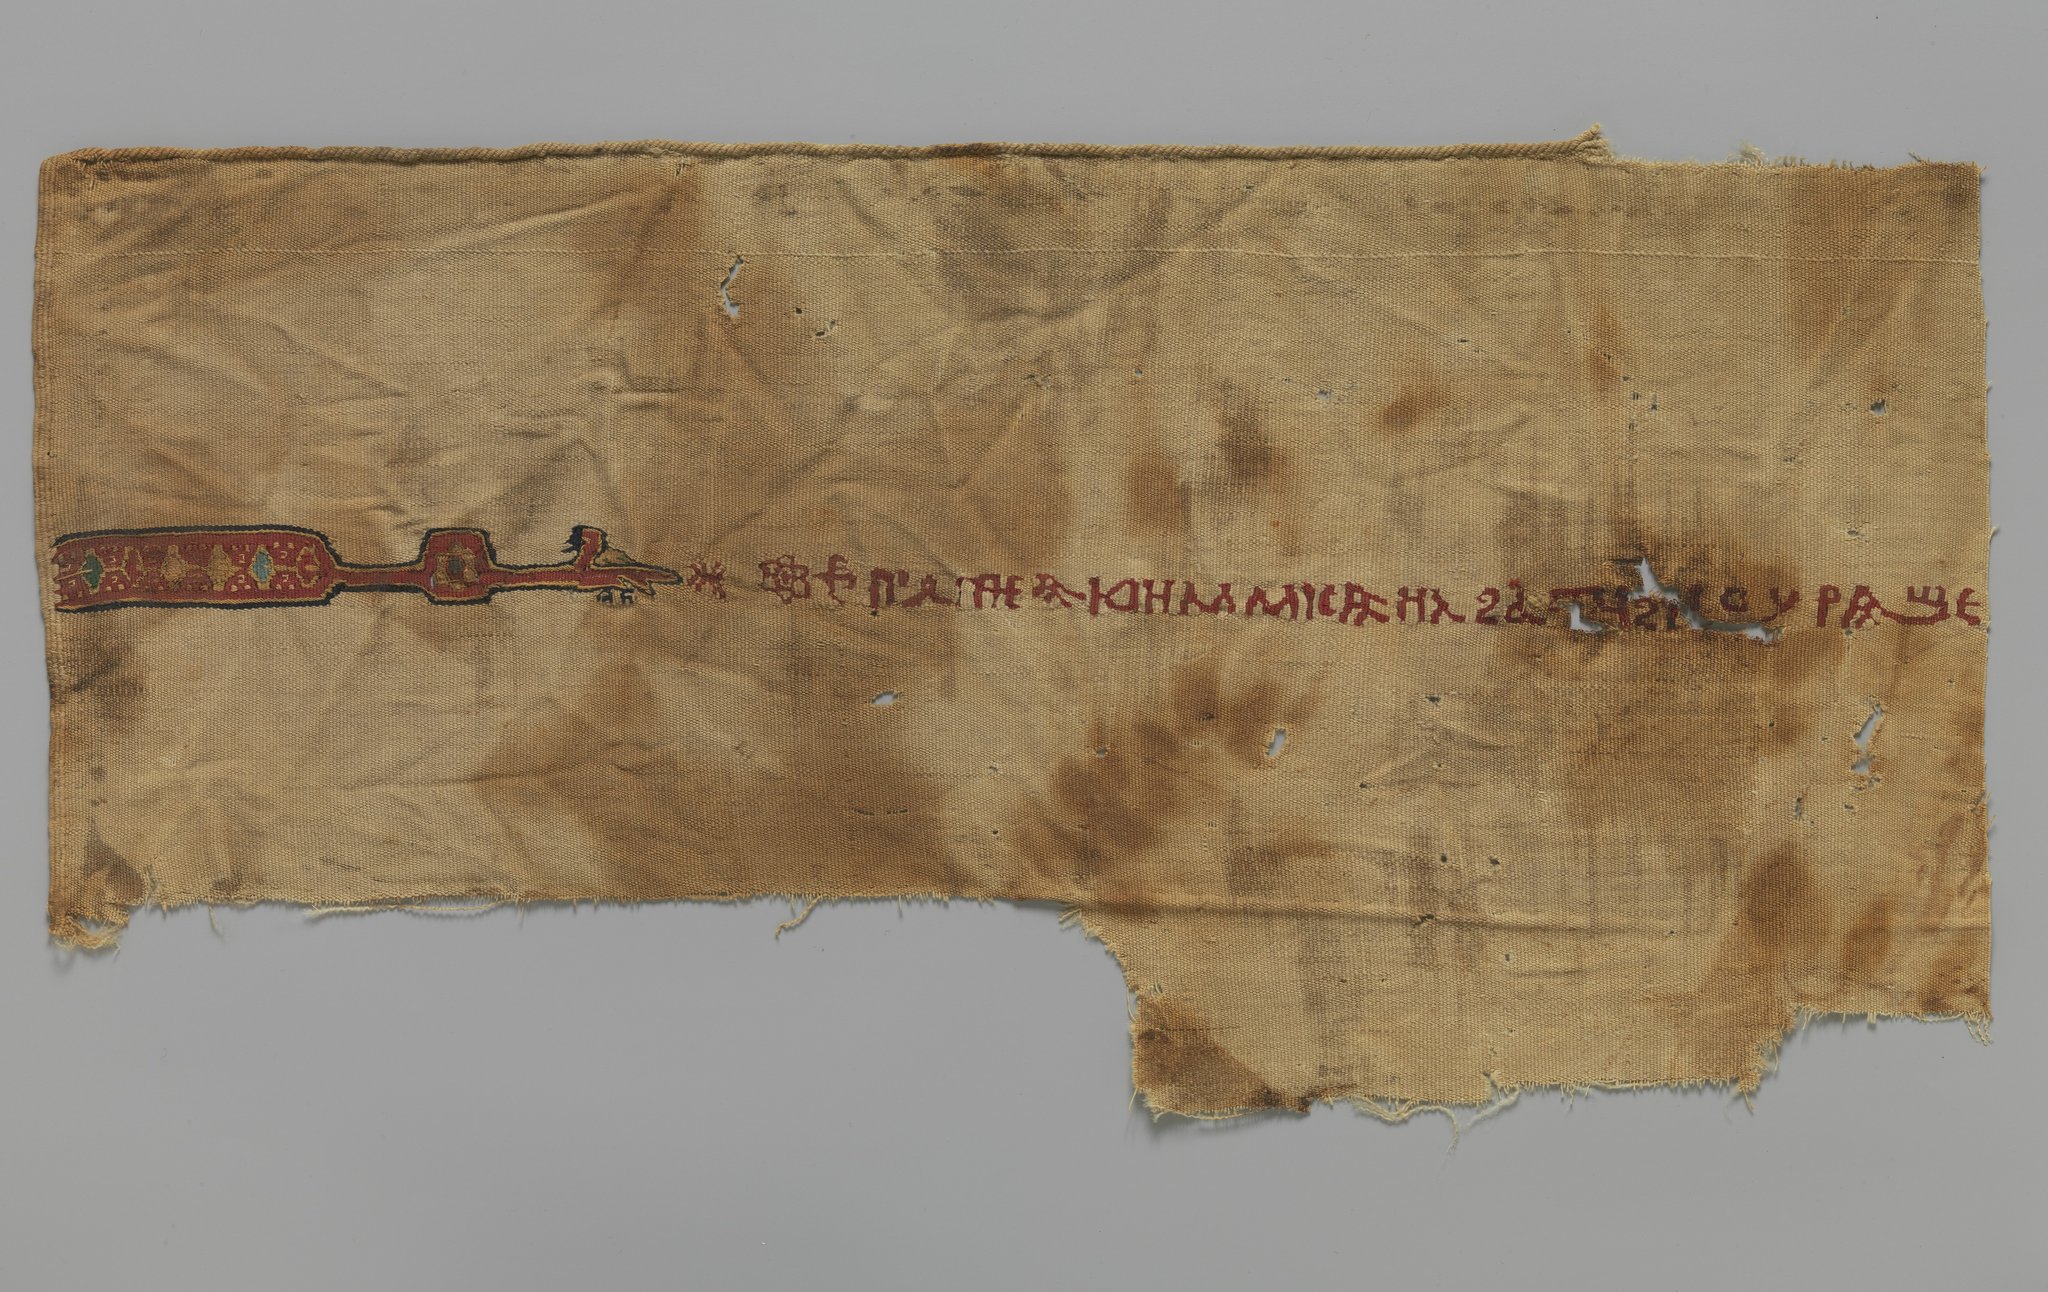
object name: textile fragment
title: Three Fragments with a Coptic Inscription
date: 810-1010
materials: wool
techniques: weave, polychrome, stitching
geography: egypt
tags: coptic